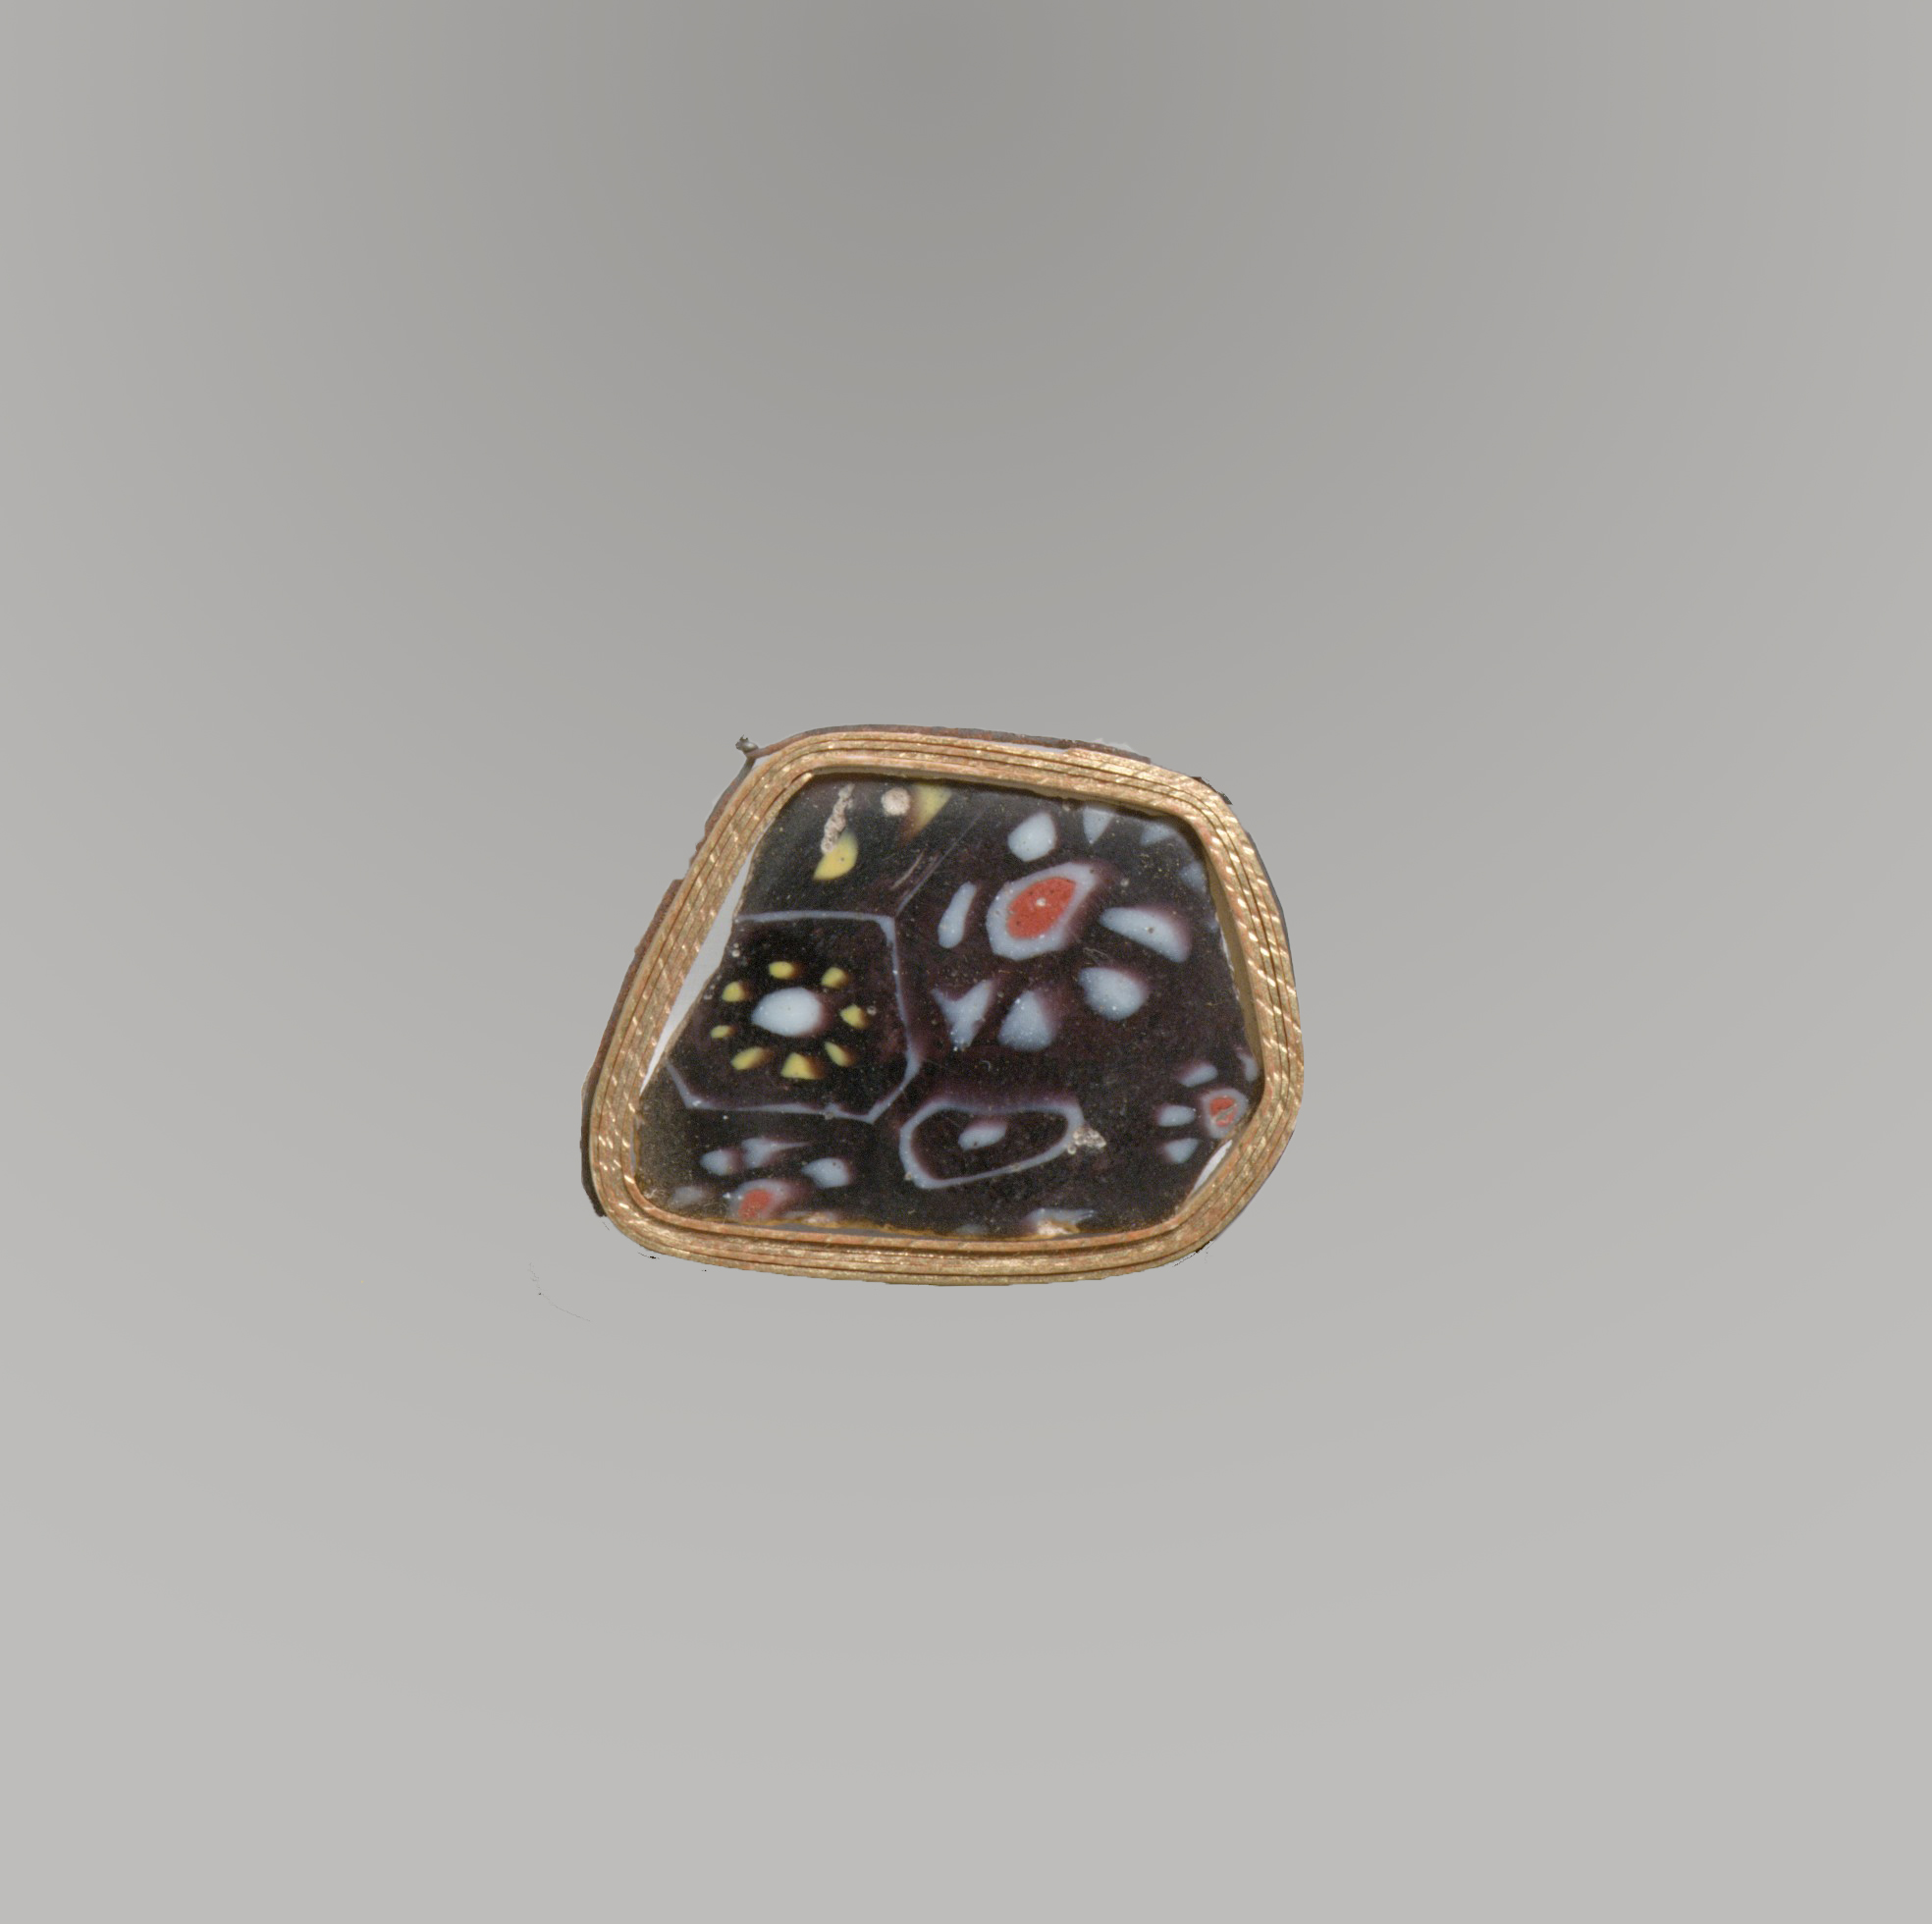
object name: fragment, mosaic bowl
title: Glass mosaic bowl fragment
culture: roman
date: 34 BCE-33 CE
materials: glass